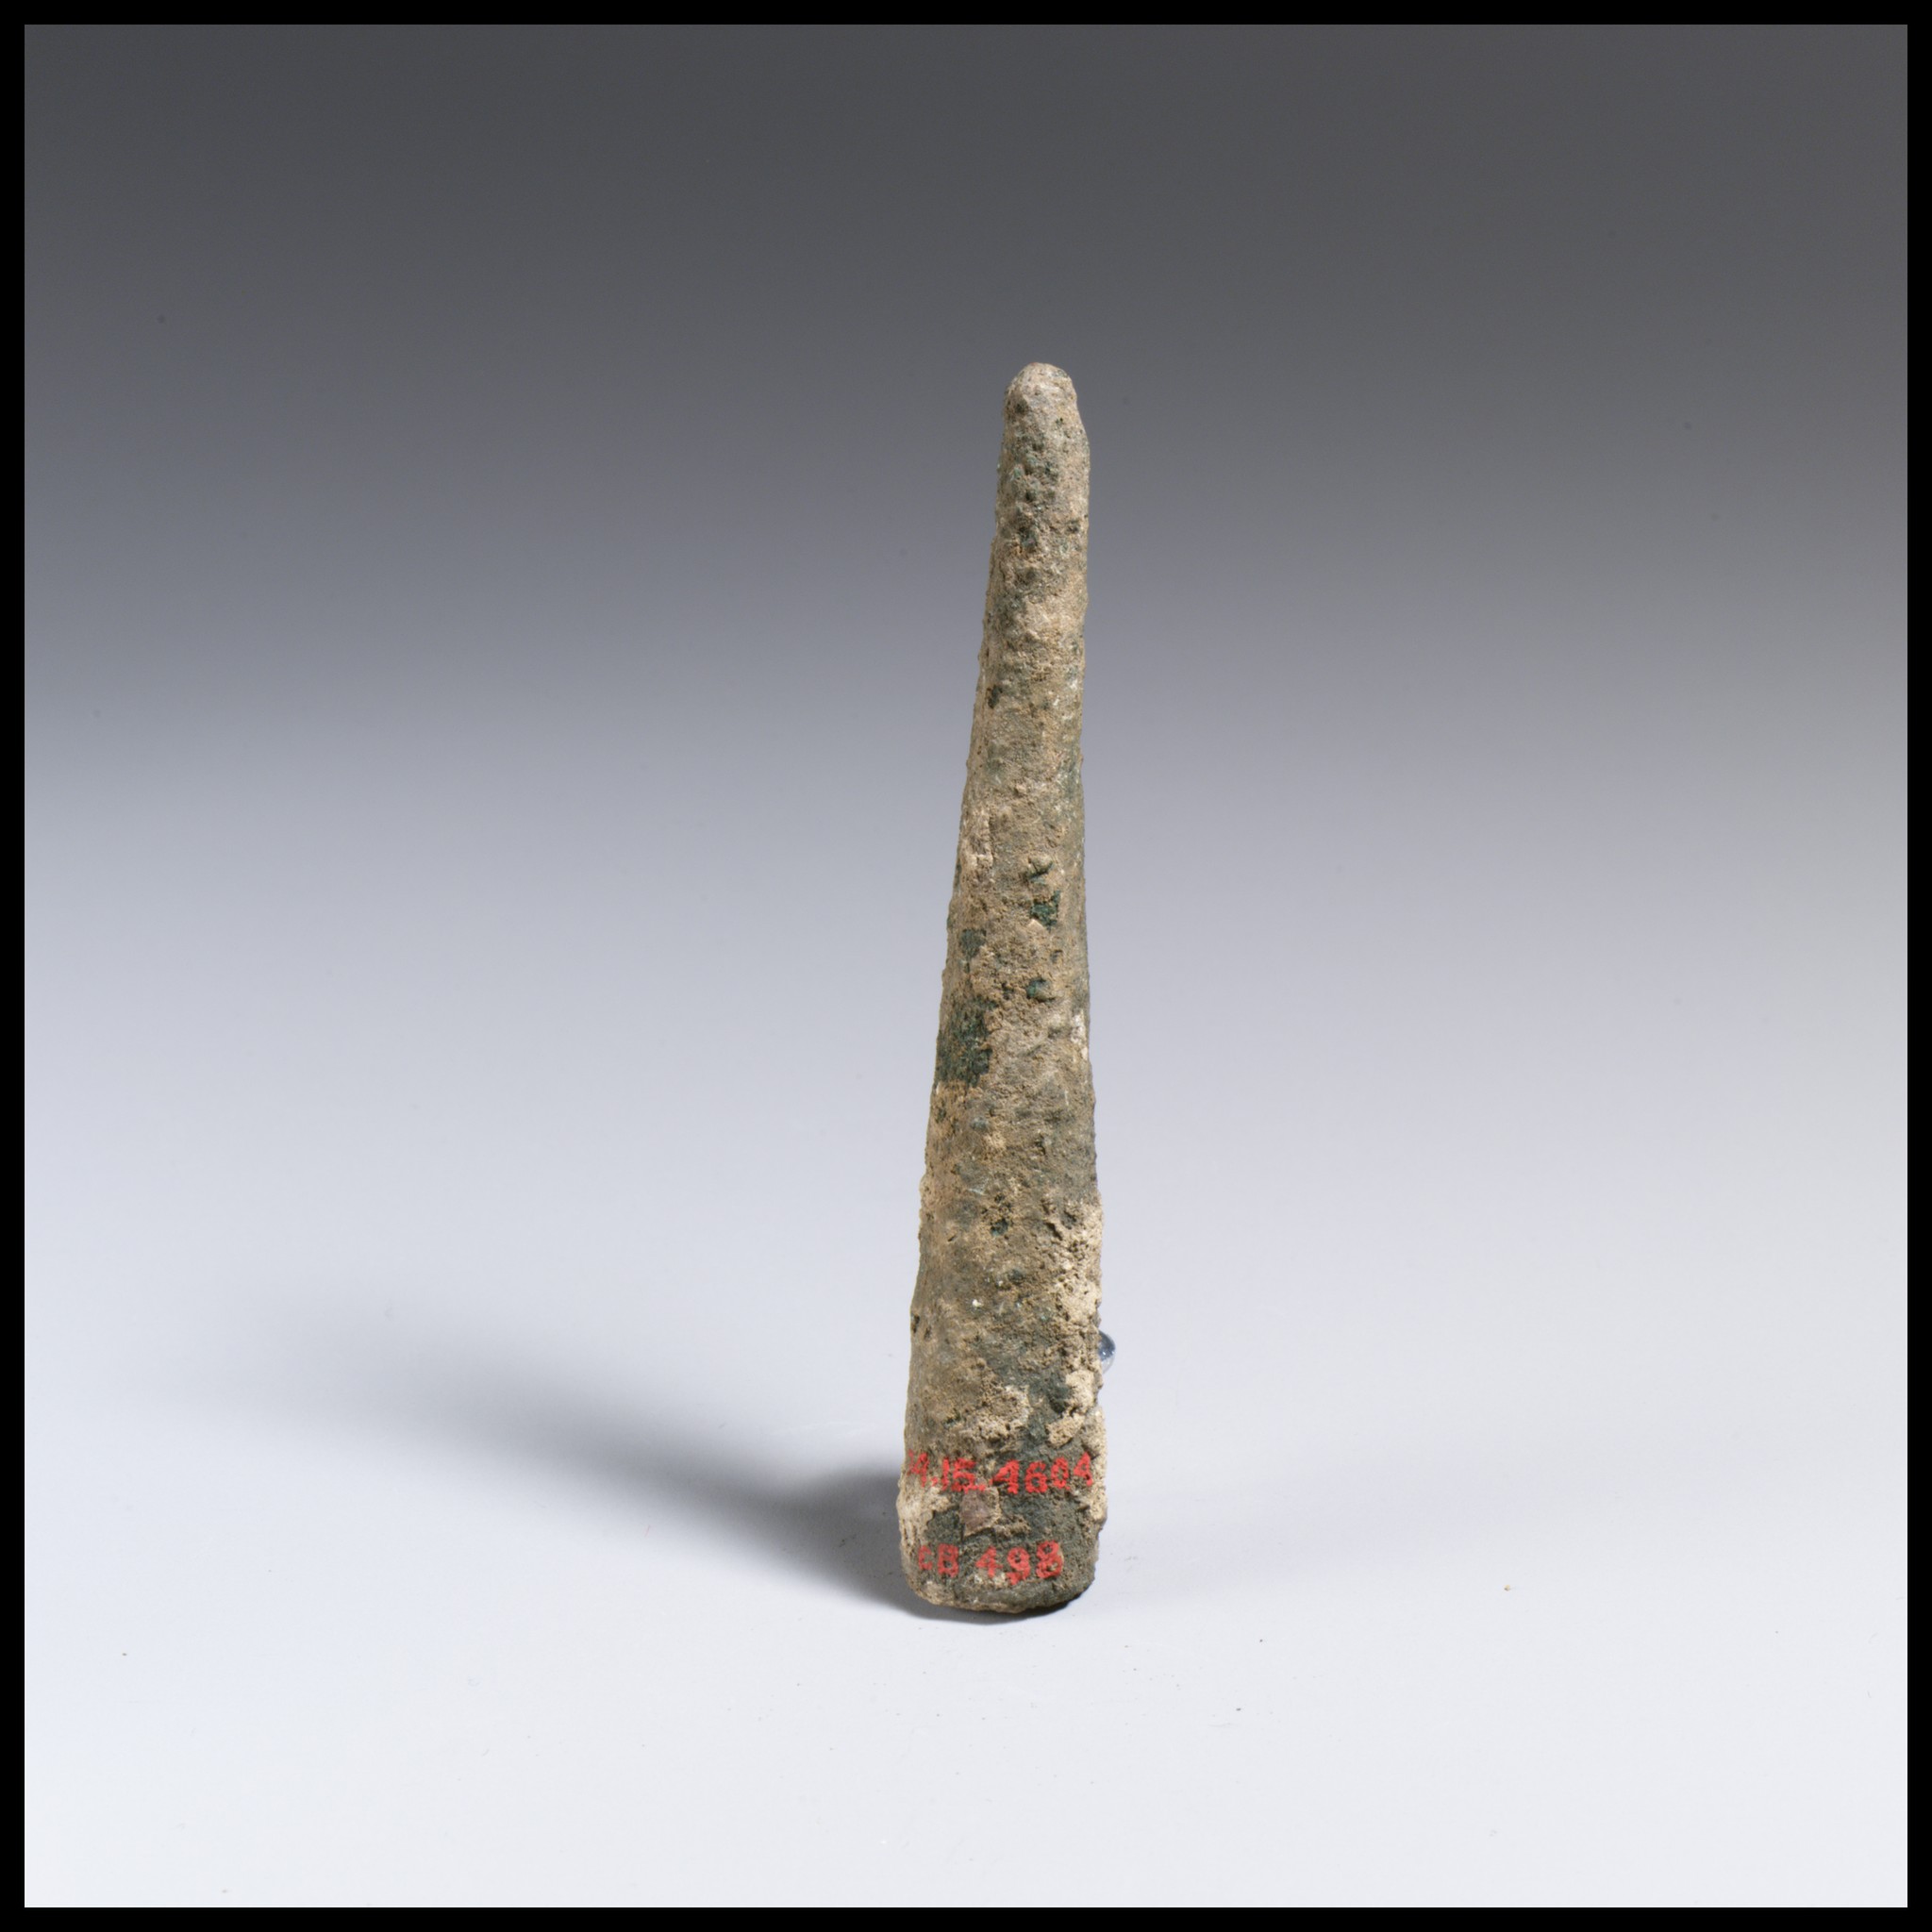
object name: spearhead or point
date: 7000 BCE-330 CE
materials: bronze